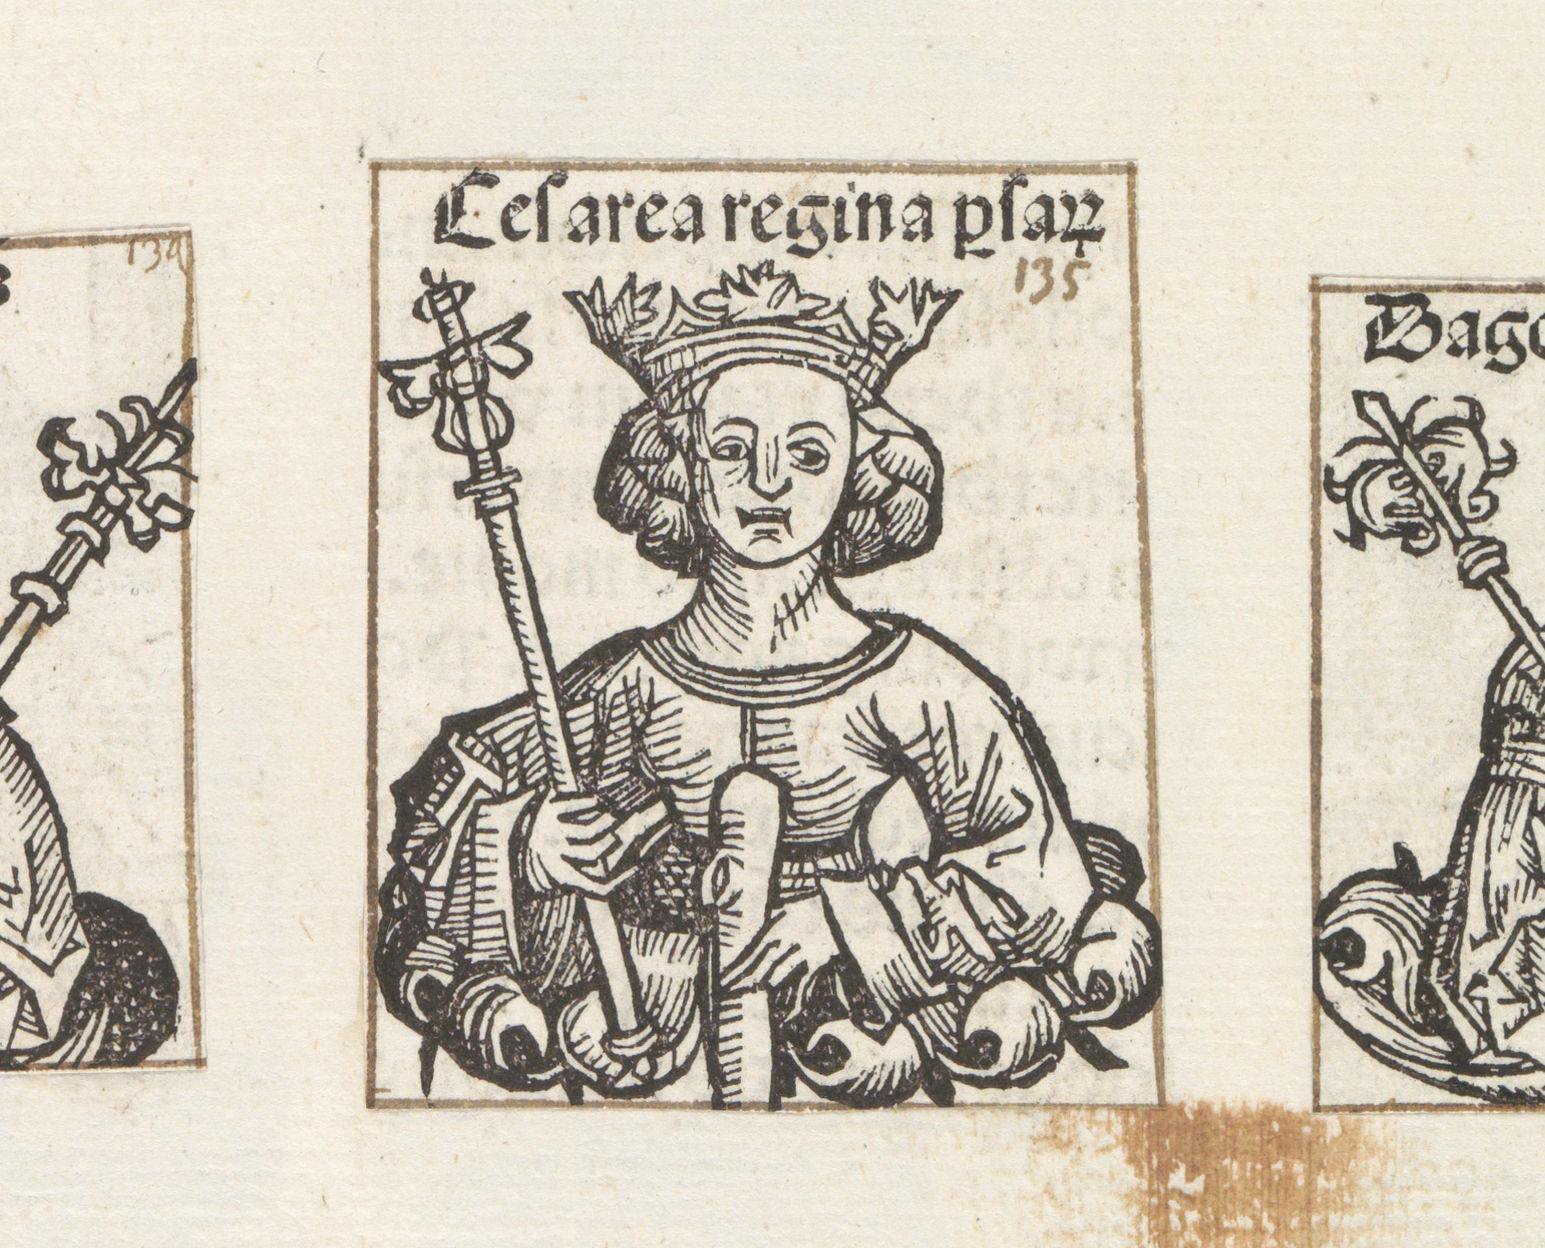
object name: print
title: Cesarea regina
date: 1493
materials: paper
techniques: letterpress printing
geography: nuremberg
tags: queen, empress, etc. (wife of a ruler)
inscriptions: inscription: ‘135’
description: De houtsnede wordt herhaaldelijk gebruikt als boekillustratie in de Liber Chronicarum (of Neurenbergkroniek) van Hartmann Schedel, verschenen in het Latijn en Duits in 1493. Zie de Latijnse uitgave, folio 155r.